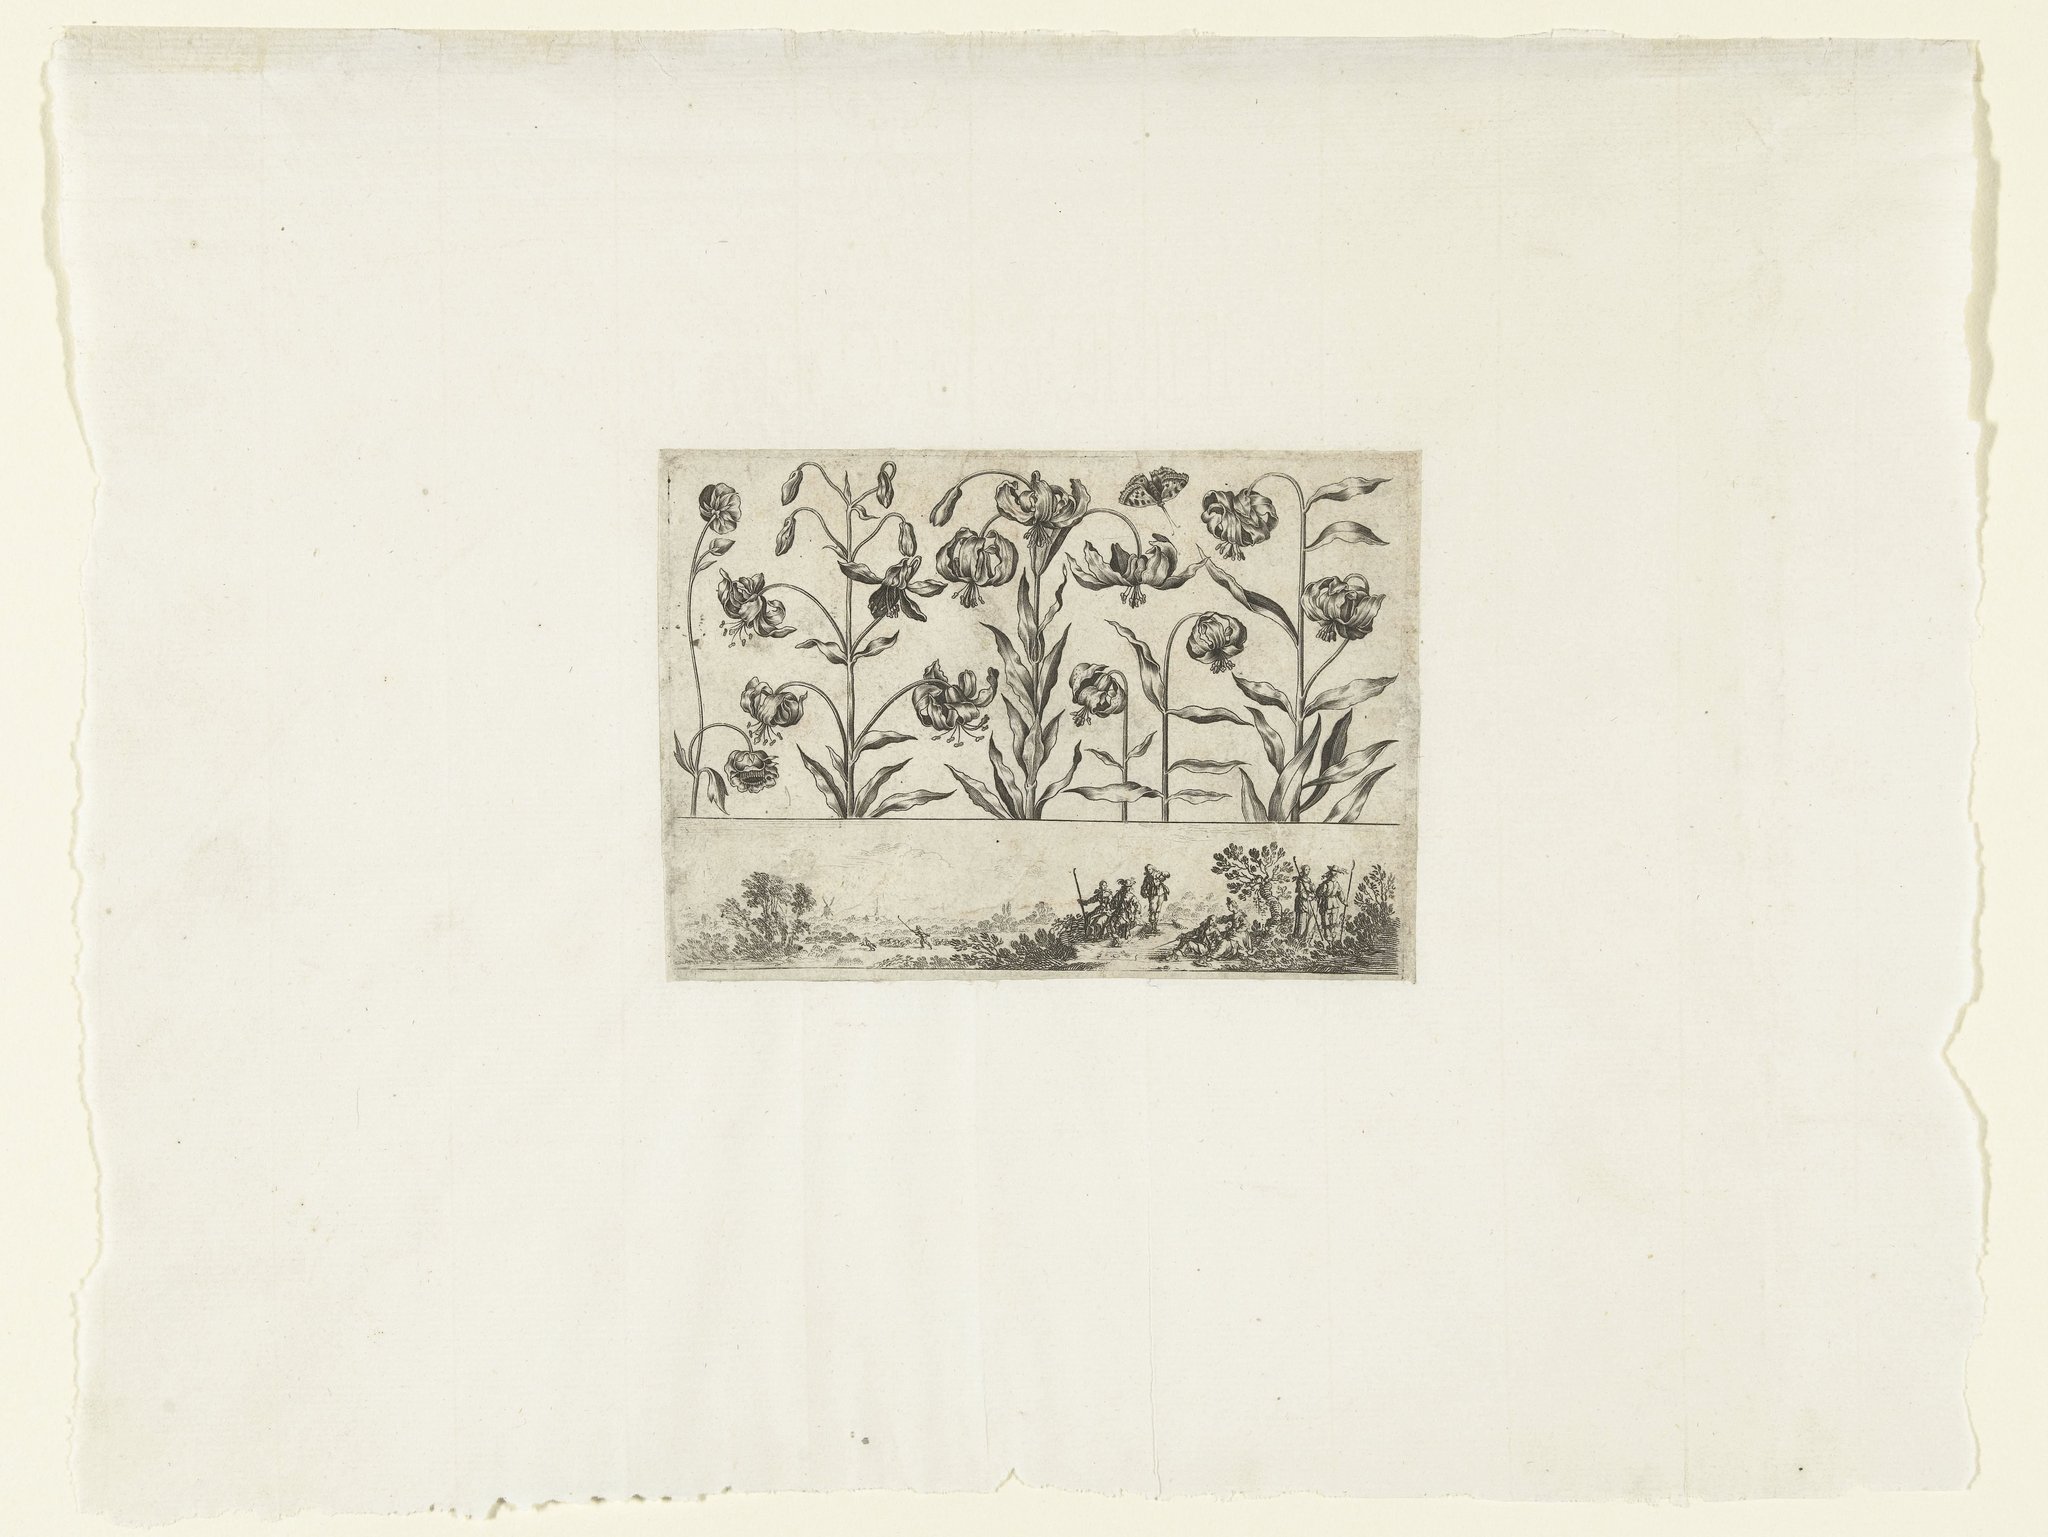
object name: print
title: Fleures Persannes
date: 1767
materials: paper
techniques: etching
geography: paris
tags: flowers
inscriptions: collector's mark: Lugt 2760, collector's mark: Lugt 2228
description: Prent is onderdeel van een serie van zes.